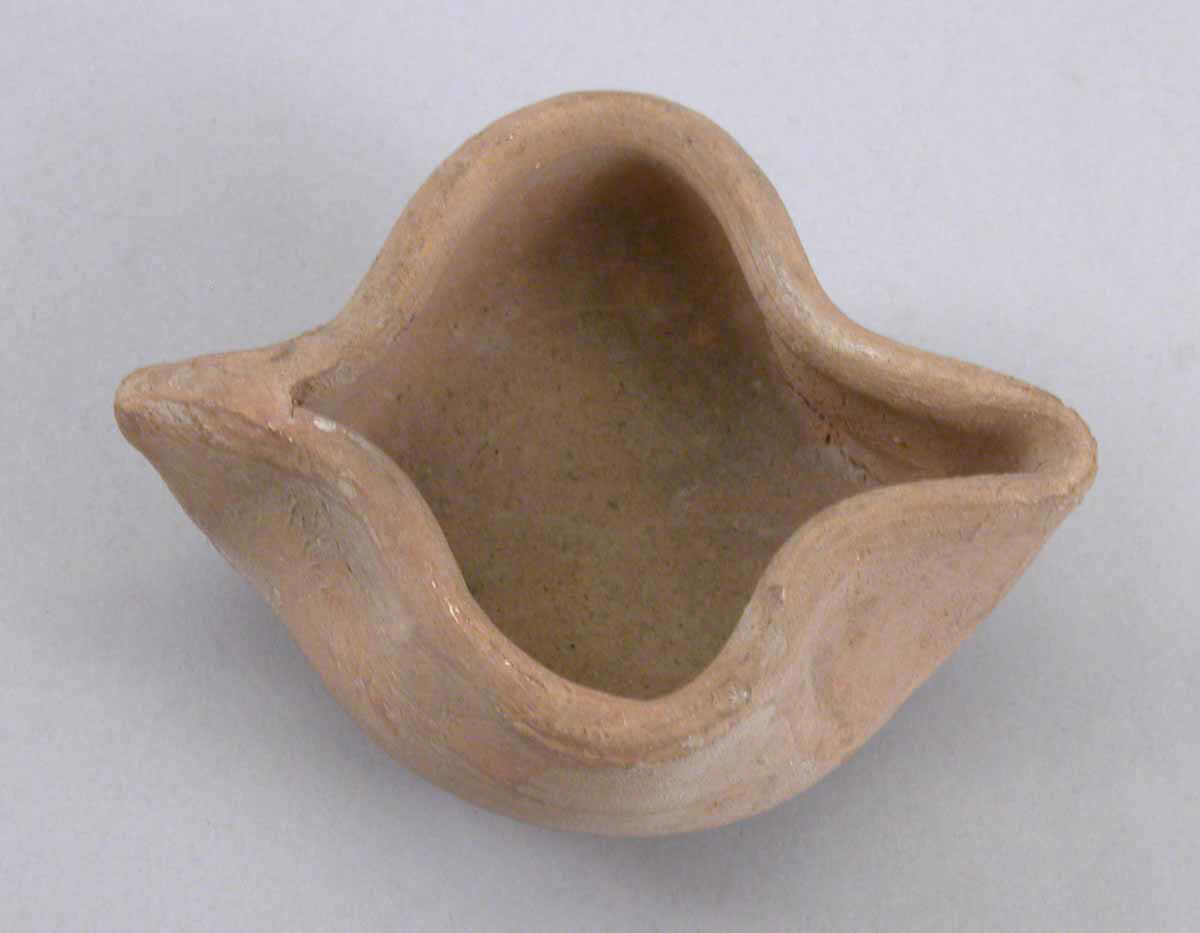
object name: lamp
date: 901-1100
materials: earthenware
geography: iran